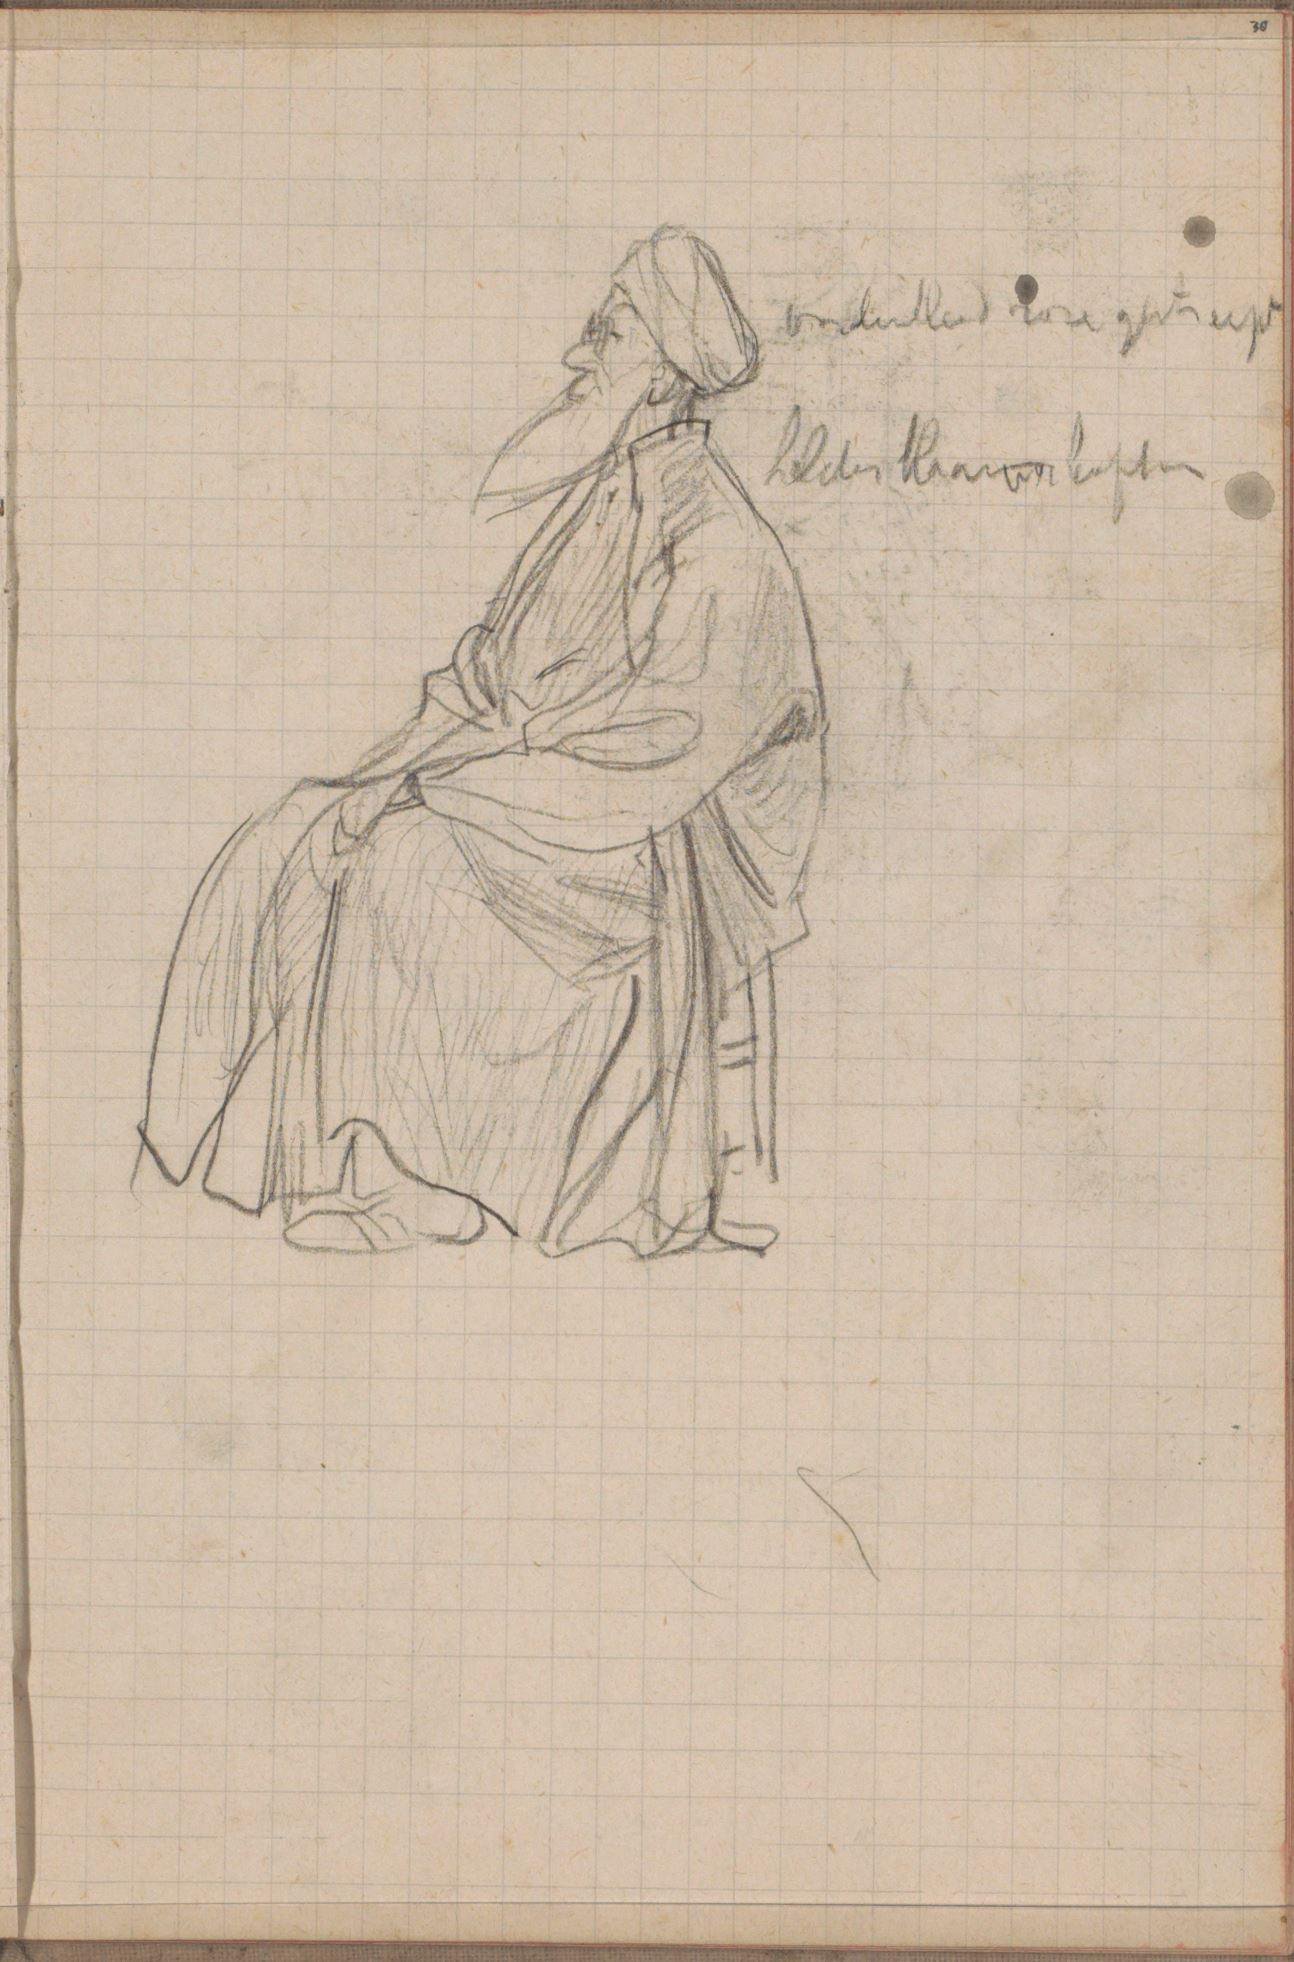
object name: sketchbook leaf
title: Zittende man in oosterse kleding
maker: marius bauer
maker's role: draughtsman, print maker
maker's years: 1867-1932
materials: chalk, paper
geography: istanbul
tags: asiatic races and peoples, sitting figure, adult man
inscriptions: kleurnotitie, handgeschreven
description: Zijaanzicht van een man met baard, bril en tulband. Pagina 38 uit een schetsboek met 51 bladen.